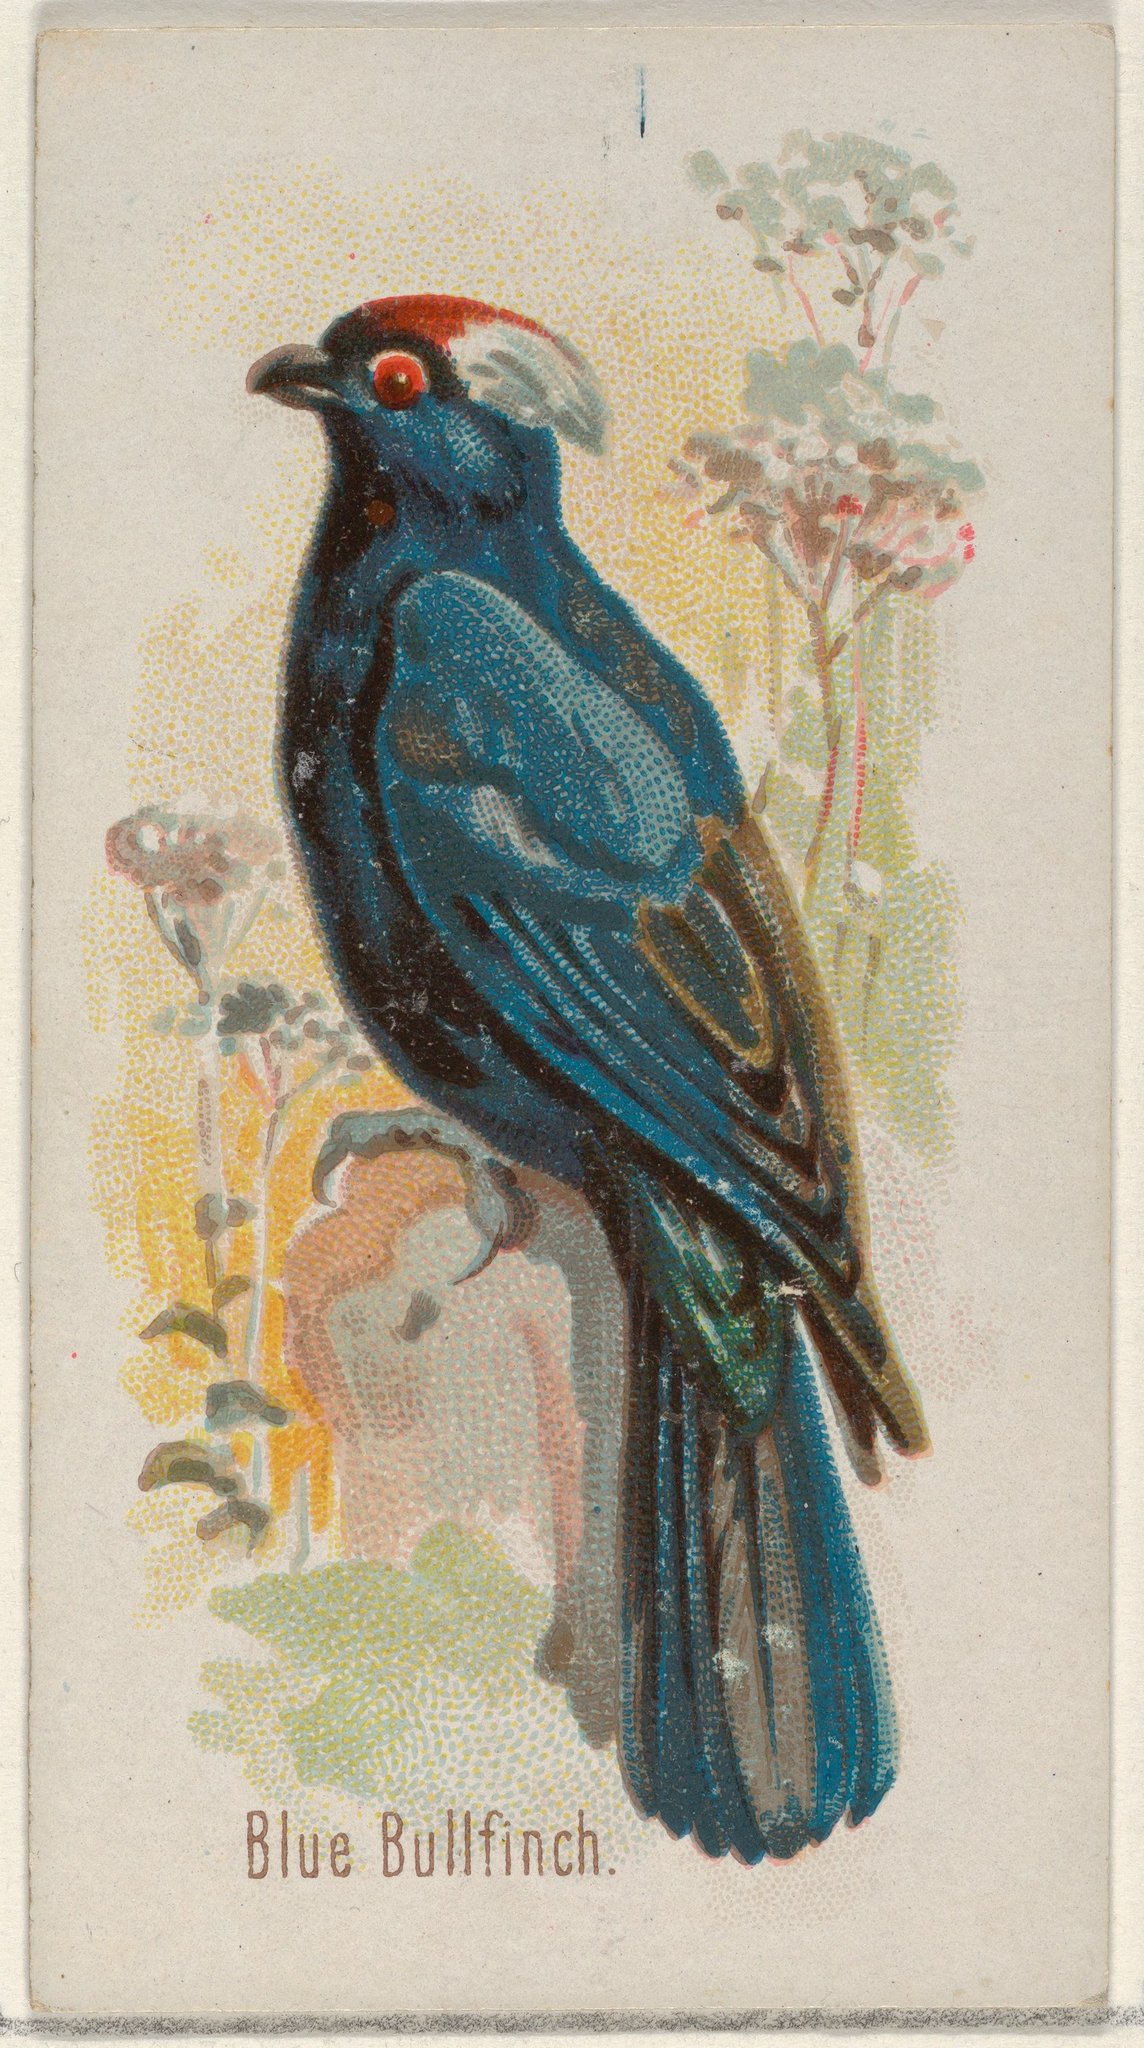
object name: print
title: Blue Bullfinch, from the Song Birds of the World series (N23) for Allen & Ginter Cigarettes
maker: allen & ginter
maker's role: publisher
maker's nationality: american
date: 1890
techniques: color lithograph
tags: birds